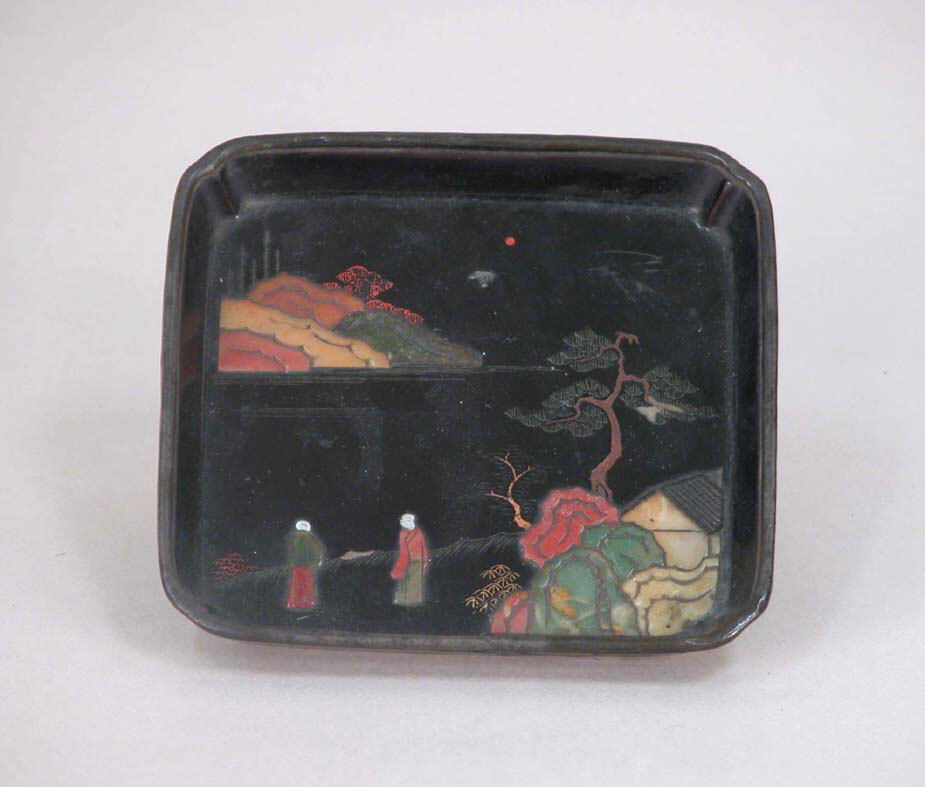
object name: tray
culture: chinese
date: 1601-1700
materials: lacquer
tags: human figures,hills